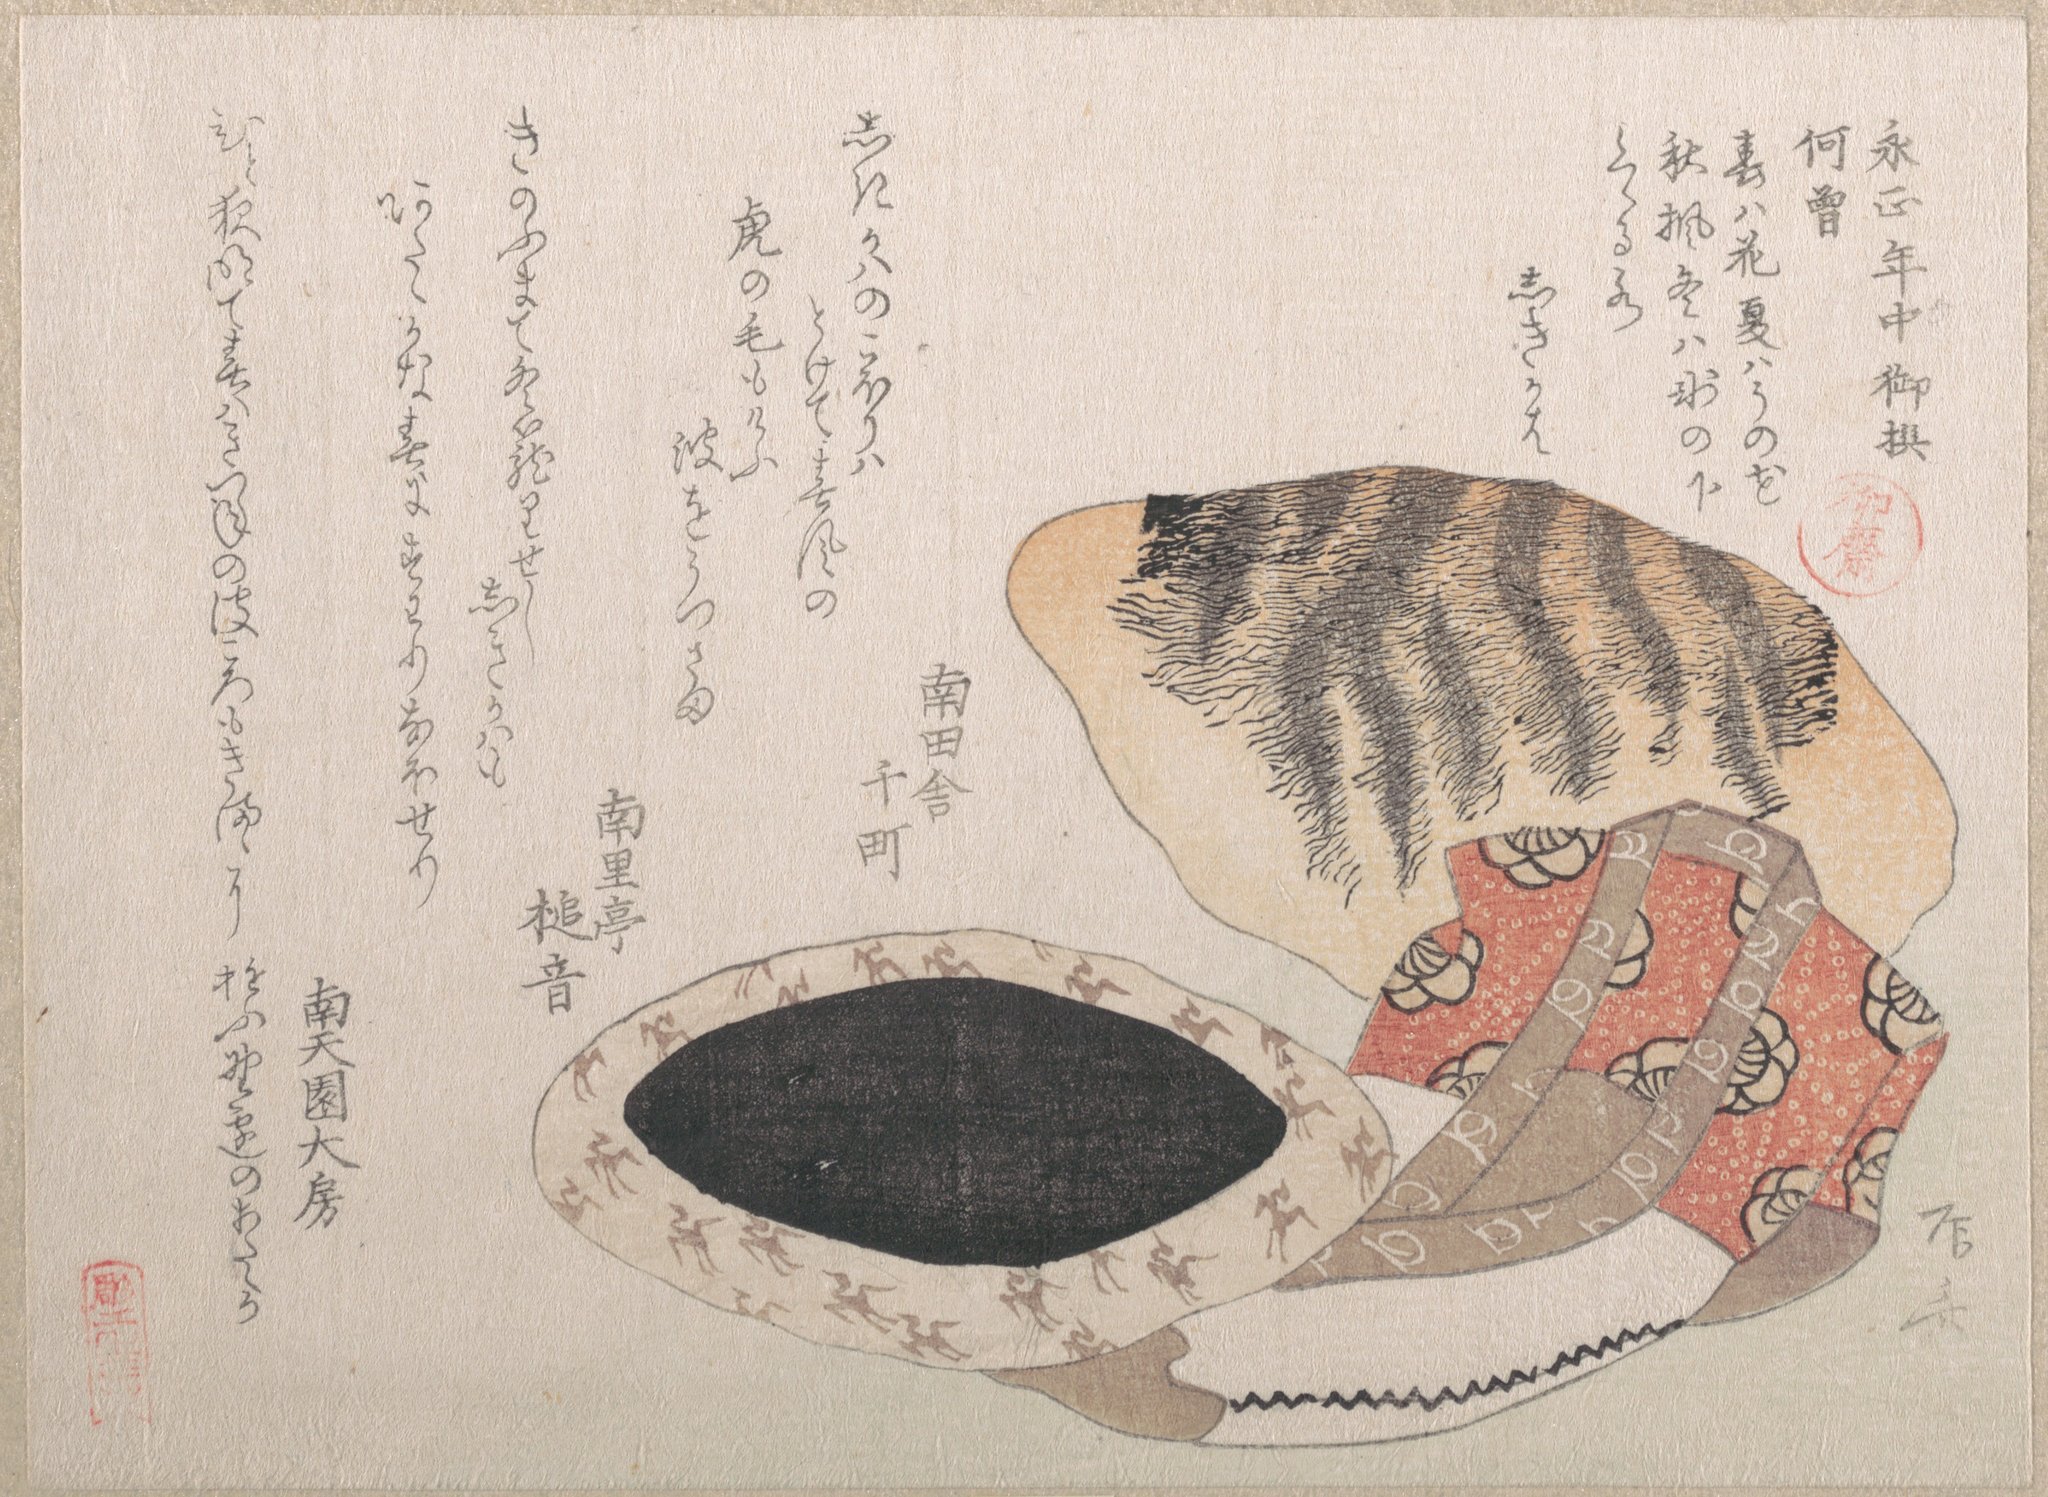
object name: woodblock print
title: Cushion, Short Coat and Fur of Tiger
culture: japanese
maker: ryūryūkyo shinsai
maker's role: artist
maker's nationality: japanese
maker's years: 1799-1823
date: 1801-1900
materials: ink, paper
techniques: surimono, woodblock print